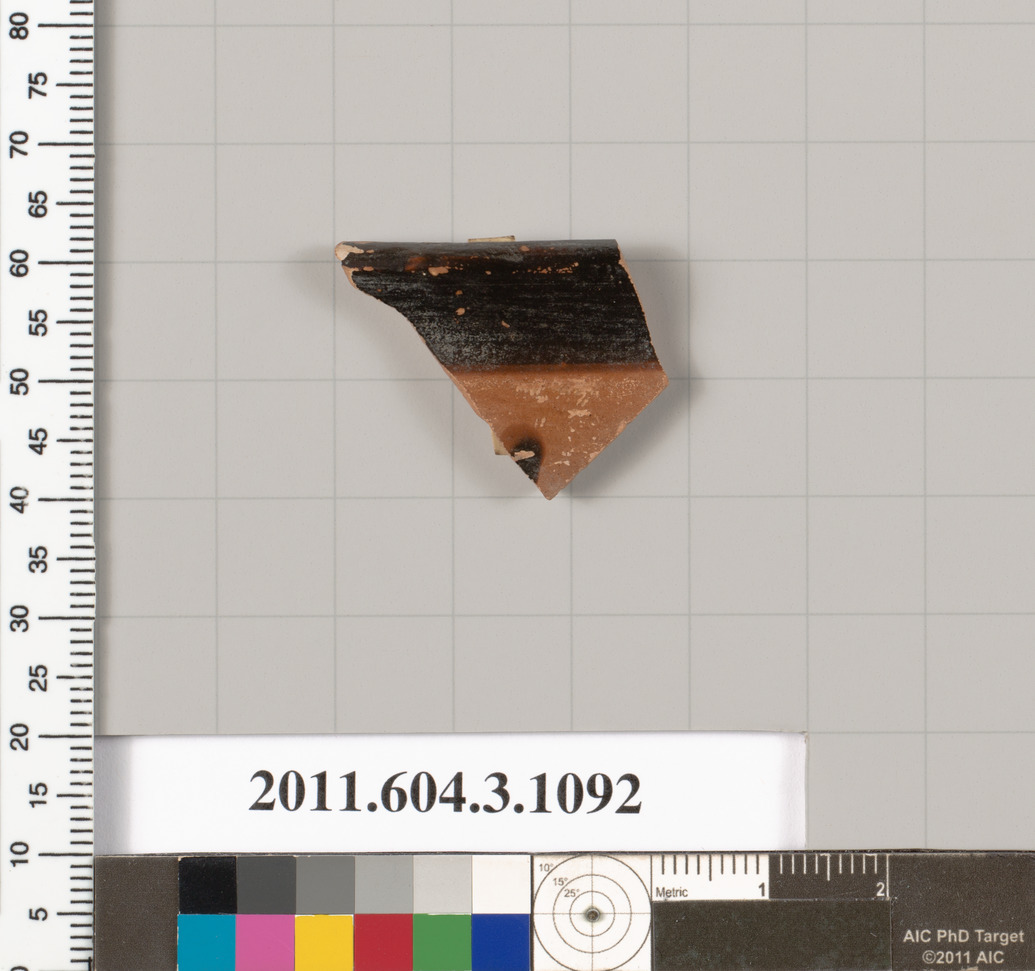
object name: mastoid fragment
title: Terracotta rim fragment of a mastoid (drinking cup with narrow base)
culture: greek, attic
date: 534-468 BCE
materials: terracotta